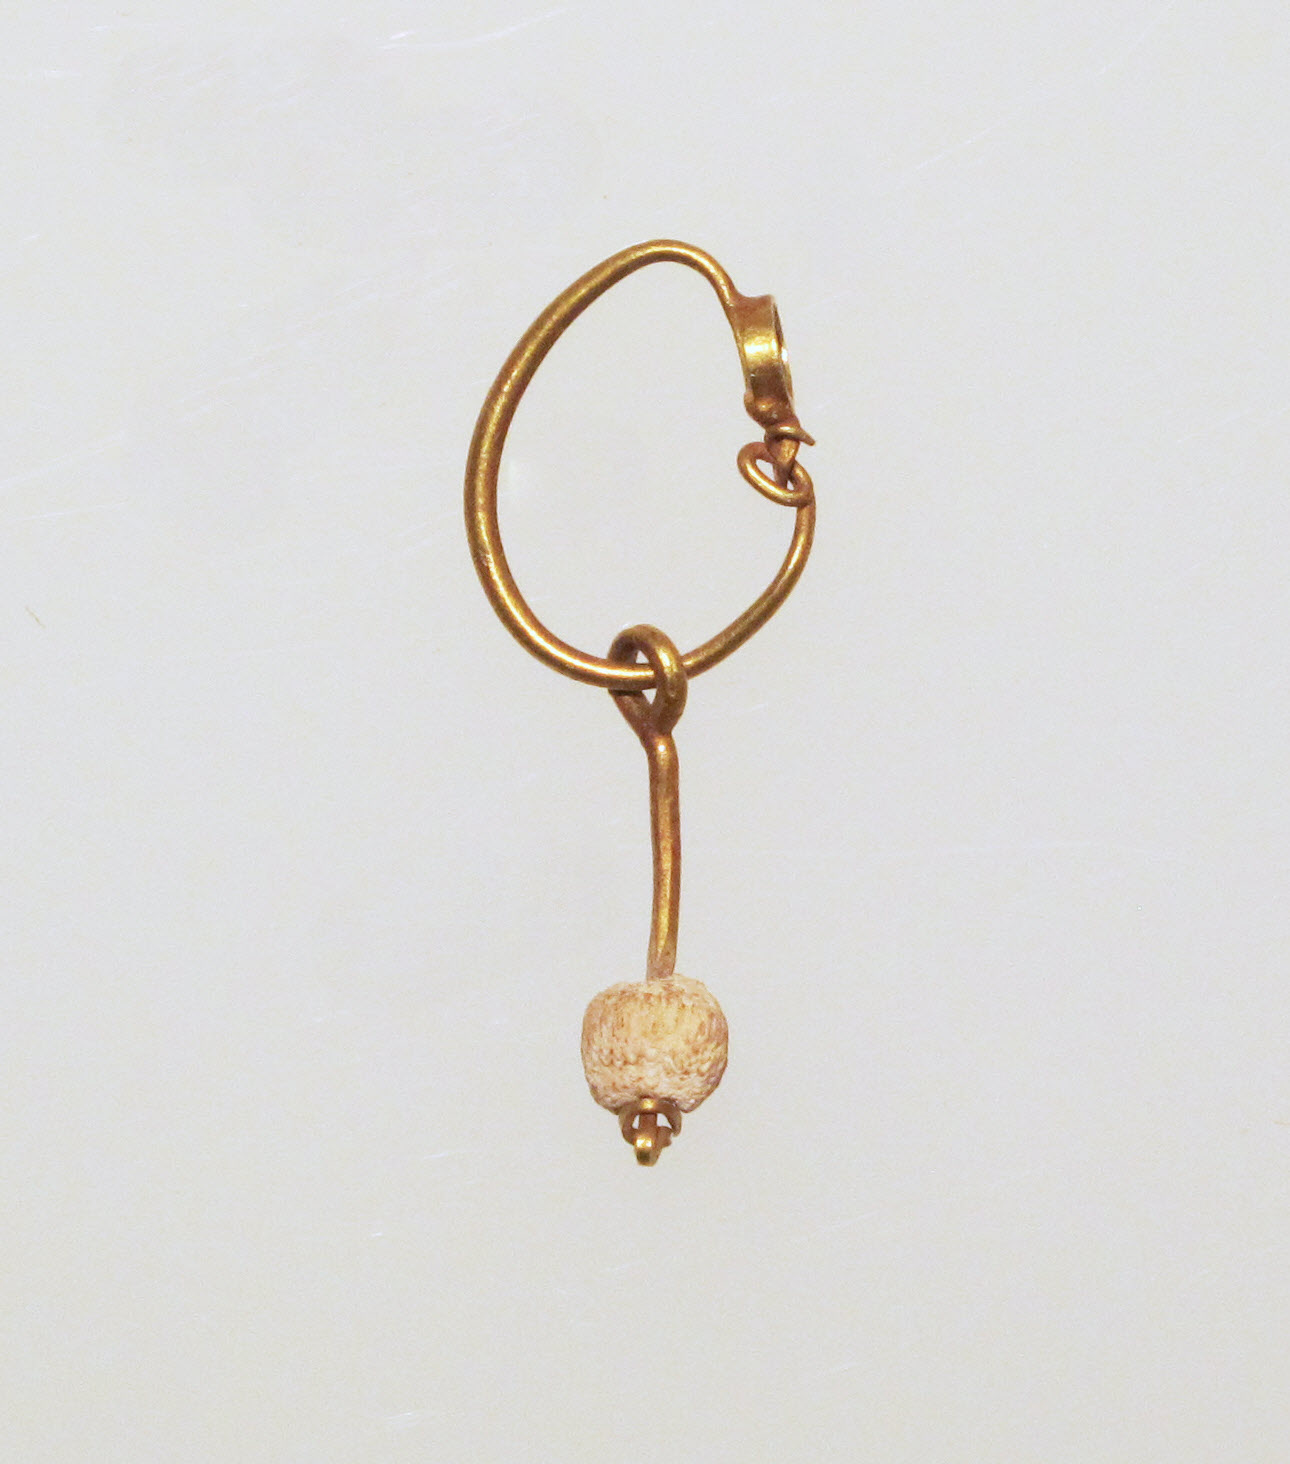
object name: earring with pendant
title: Gold earring with pearl pendant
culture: roman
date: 1-200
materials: gold